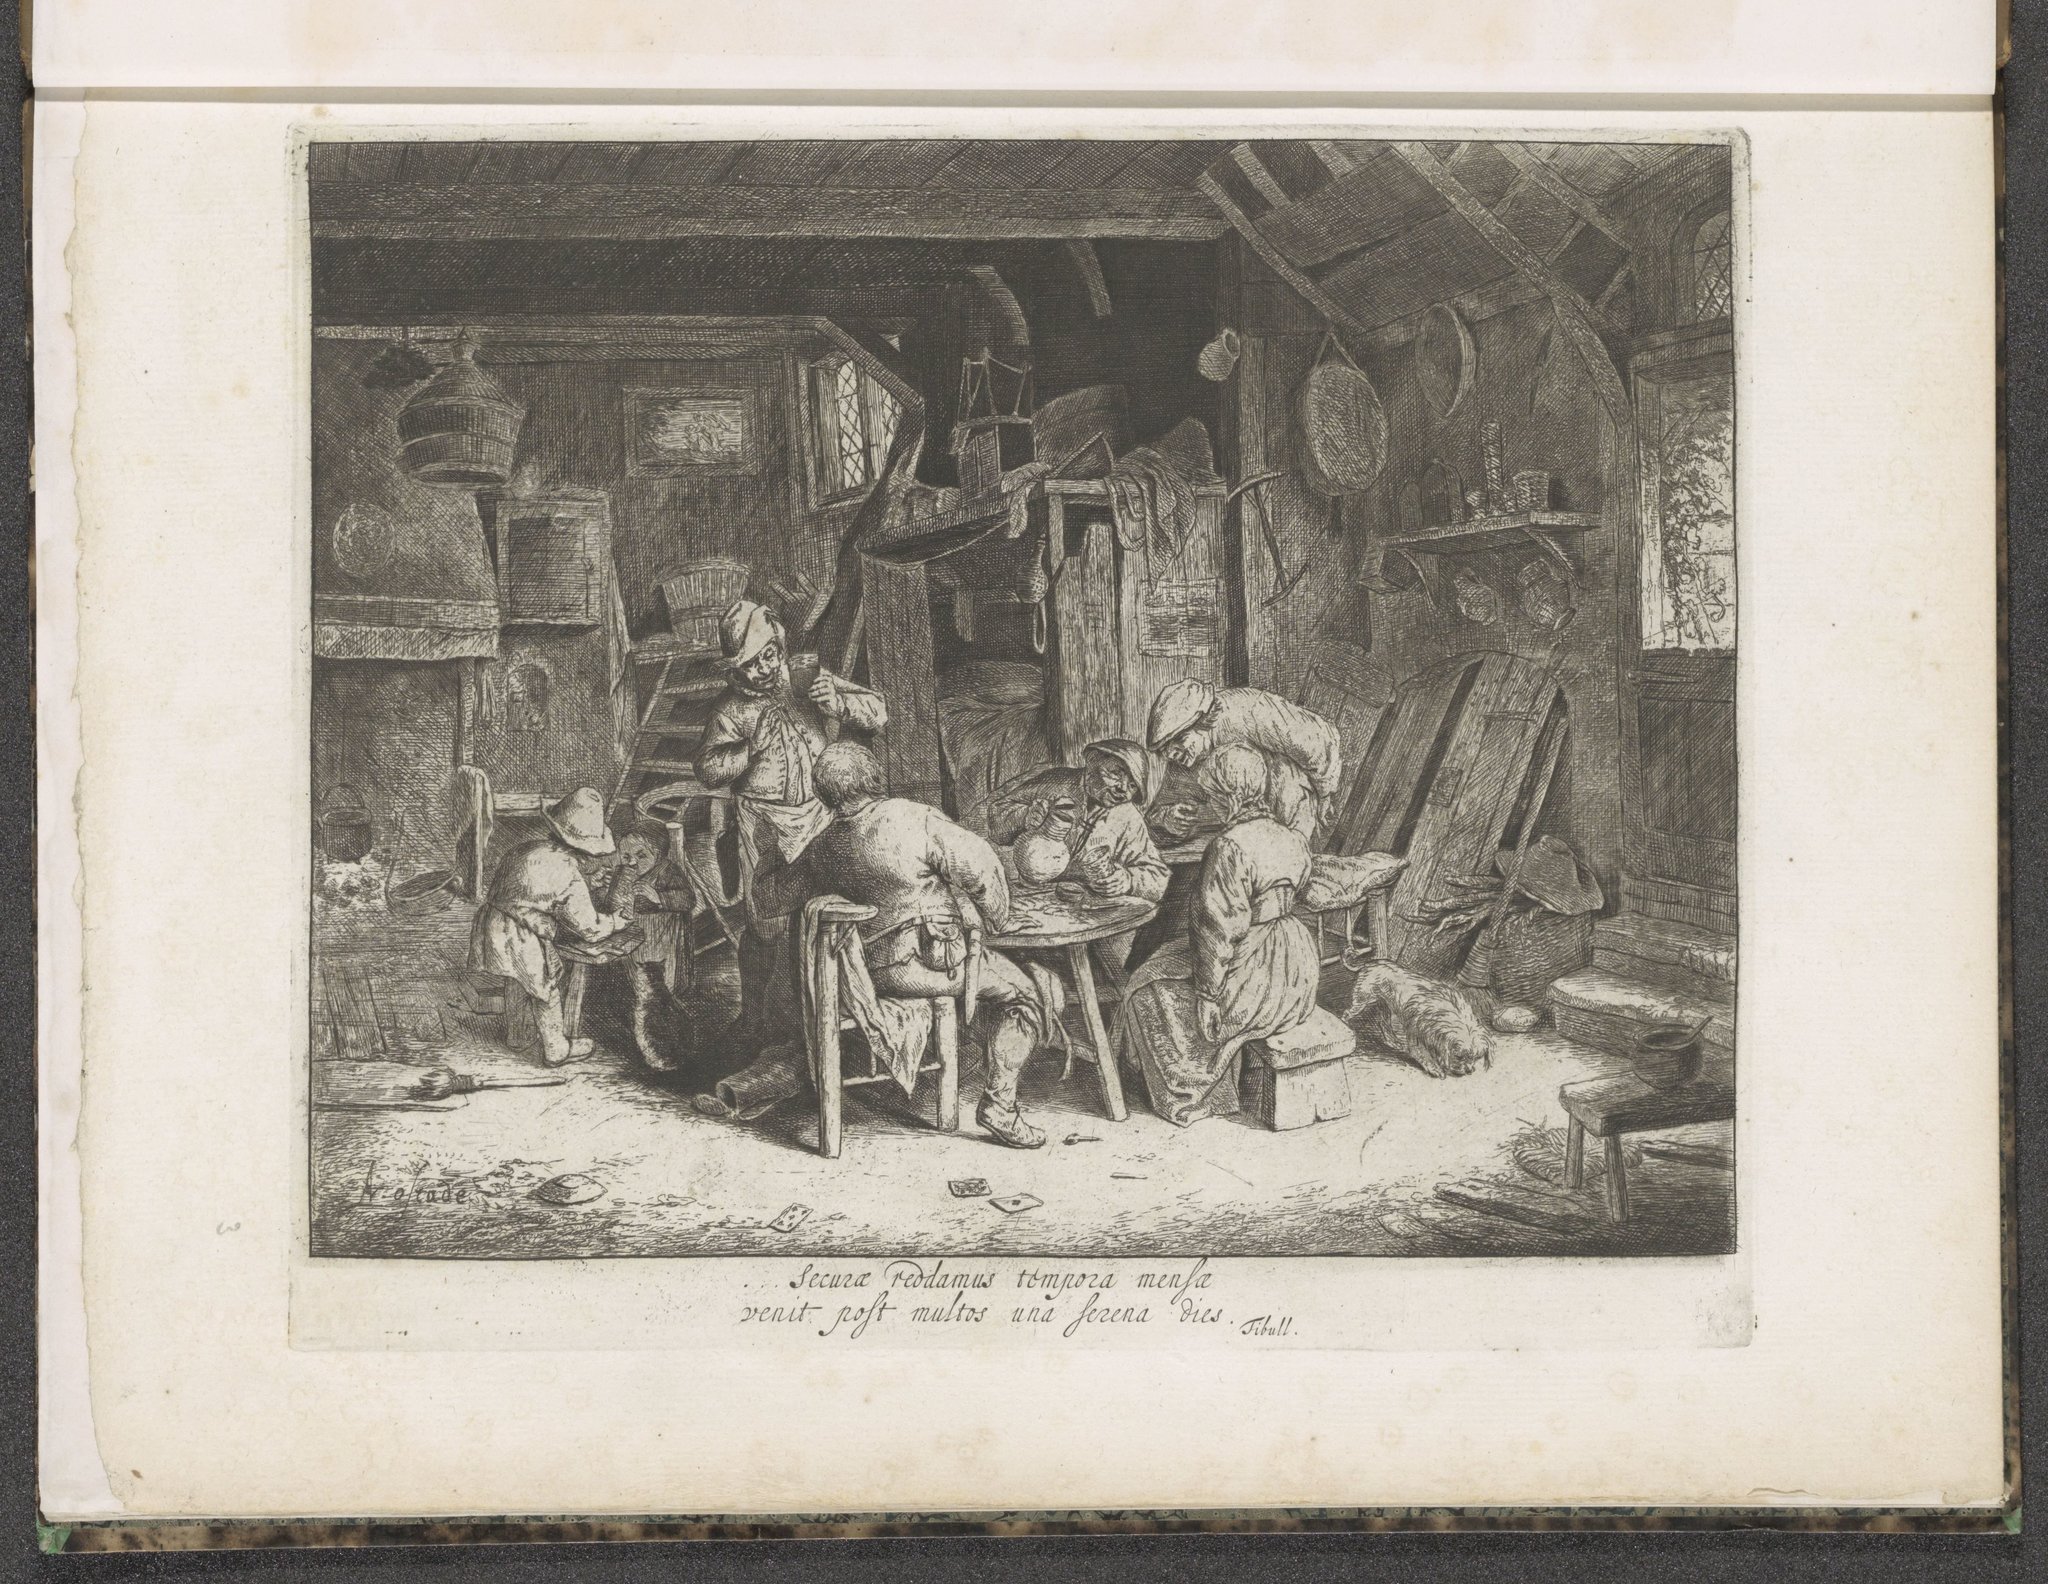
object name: album leaf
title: Boeren aan een maaltijd in een herberg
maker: adriaen van ostade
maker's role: draughtsman, painter, print maker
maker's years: 1610-1685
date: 1647-1652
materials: paper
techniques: drypoint, etching, intaglio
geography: haarlem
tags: inn, coffee-house, public house, etc., (family) meal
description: Vier mannen en een vrouw rond een gedekte tafel in een herberg. Een jongen helpt een klein kind bij het drinken uit een kruik. Op de grond speelkaarten, een gebroken pijp en een lege kan. Onderaan een tweeregelig vers in het Latijn van de dichter Tibullus. Deze prent maakt deel uit van een album.